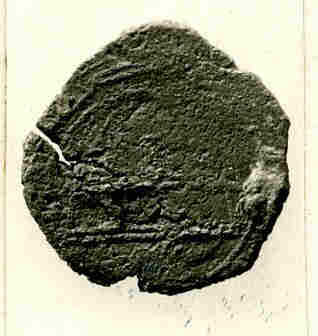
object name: coin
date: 701-900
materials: copper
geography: iran